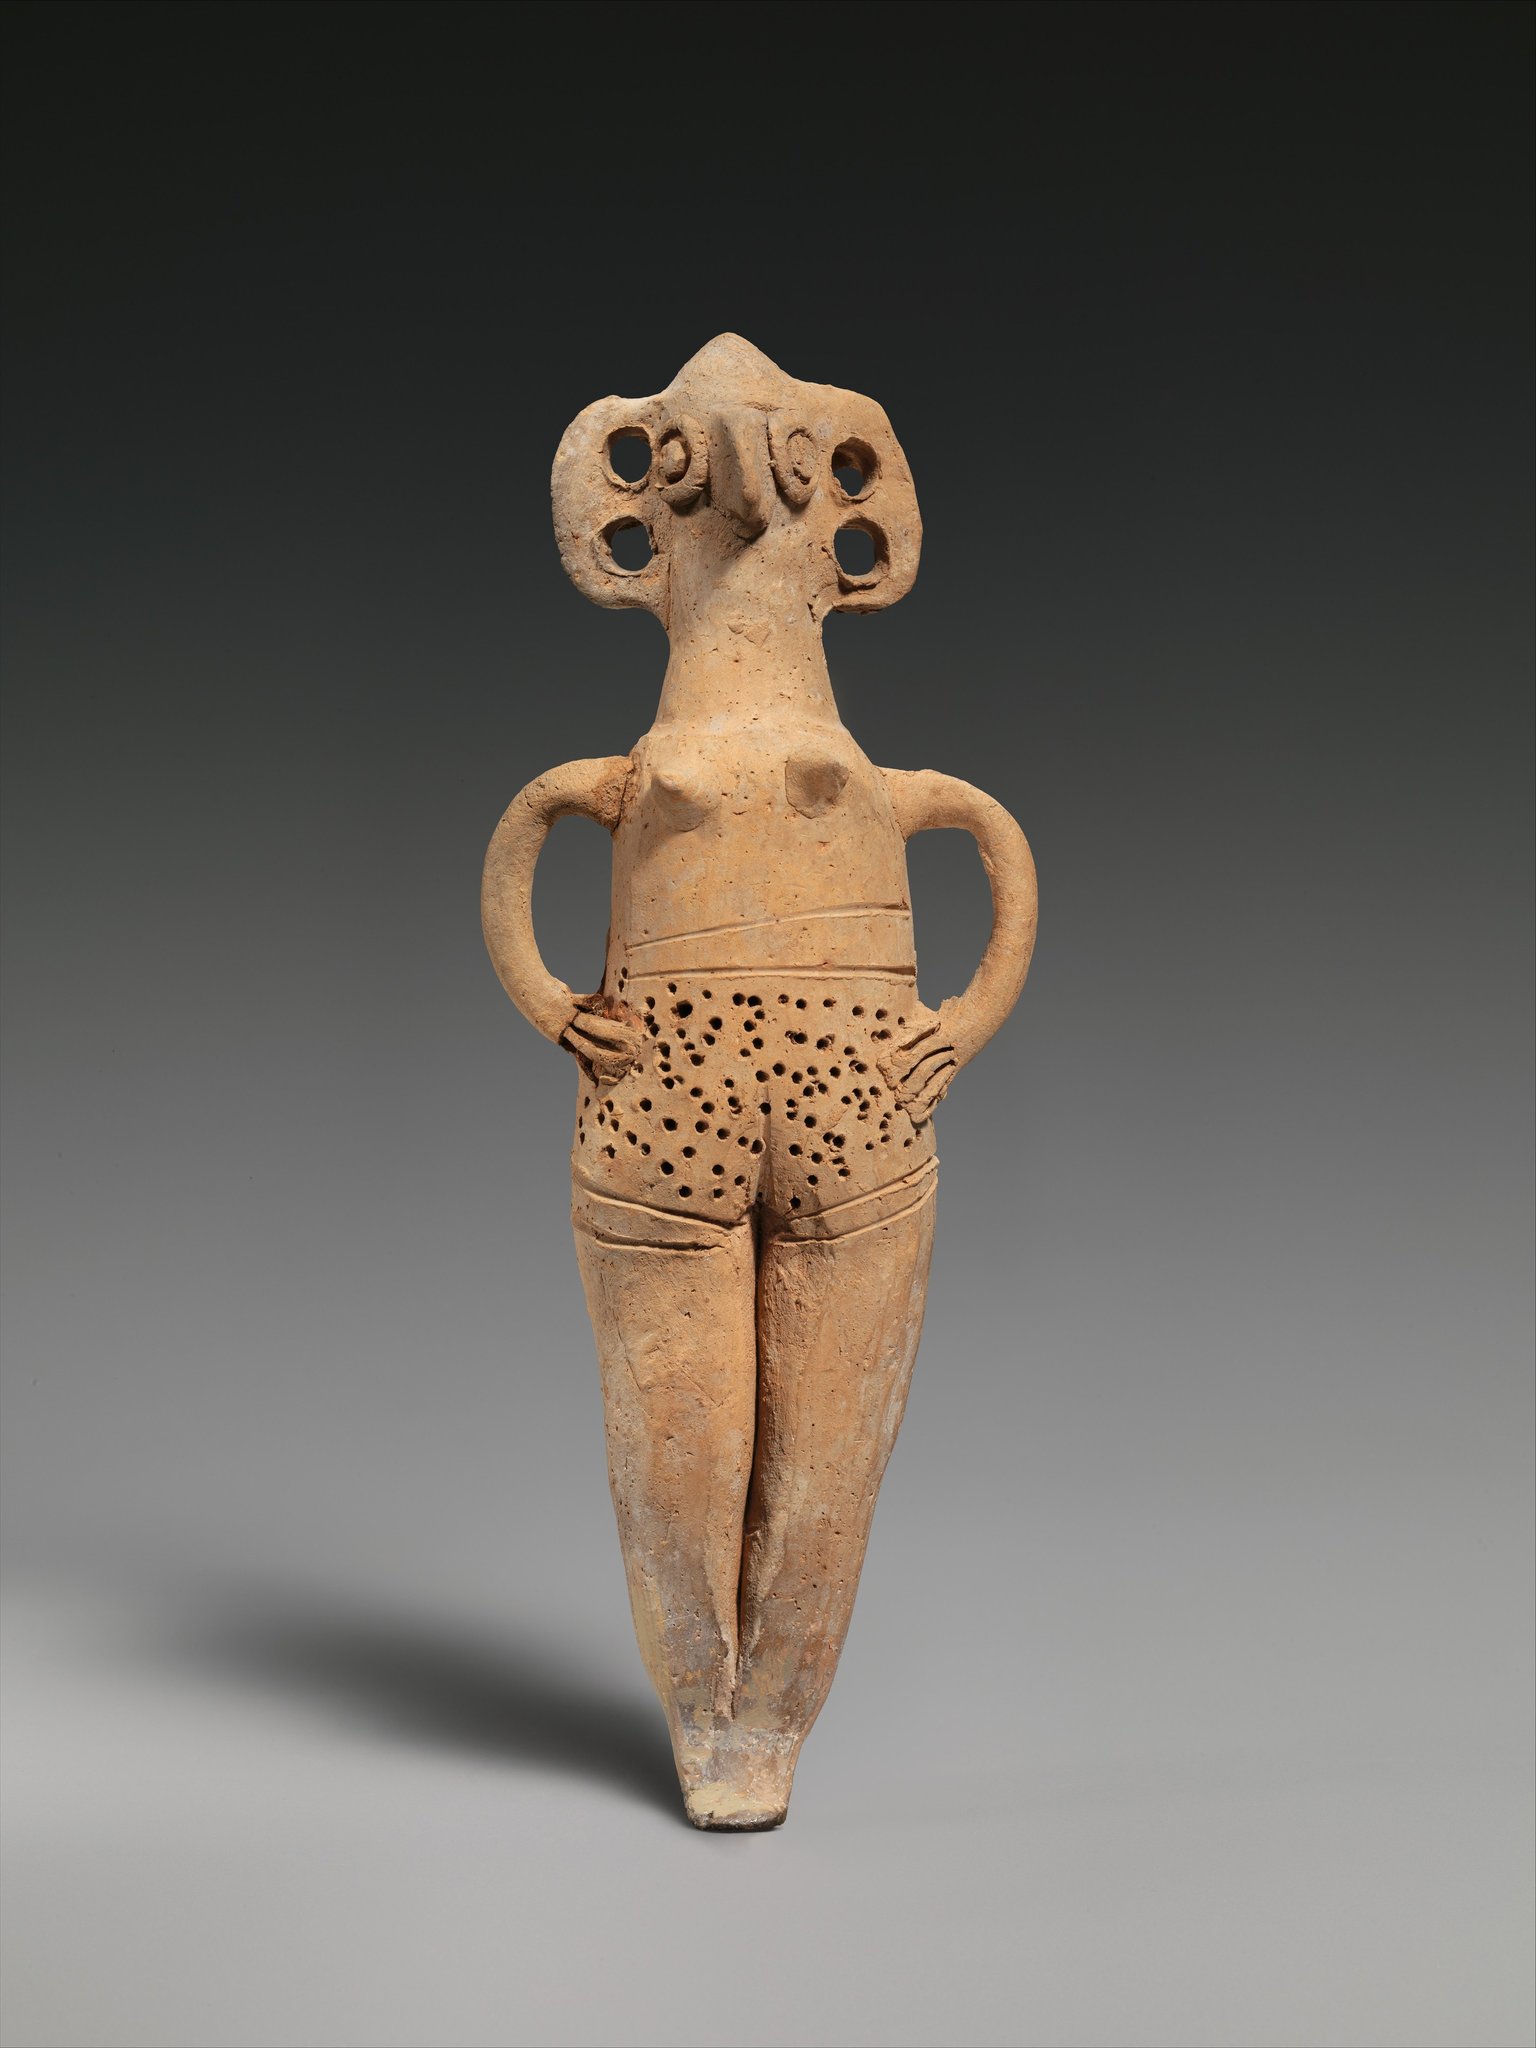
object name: statuette of a woman with bird face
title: Terracotta statuette of woman with bird face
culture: cypriot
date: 1450-1200 BCE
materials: terracotta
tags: birds,women